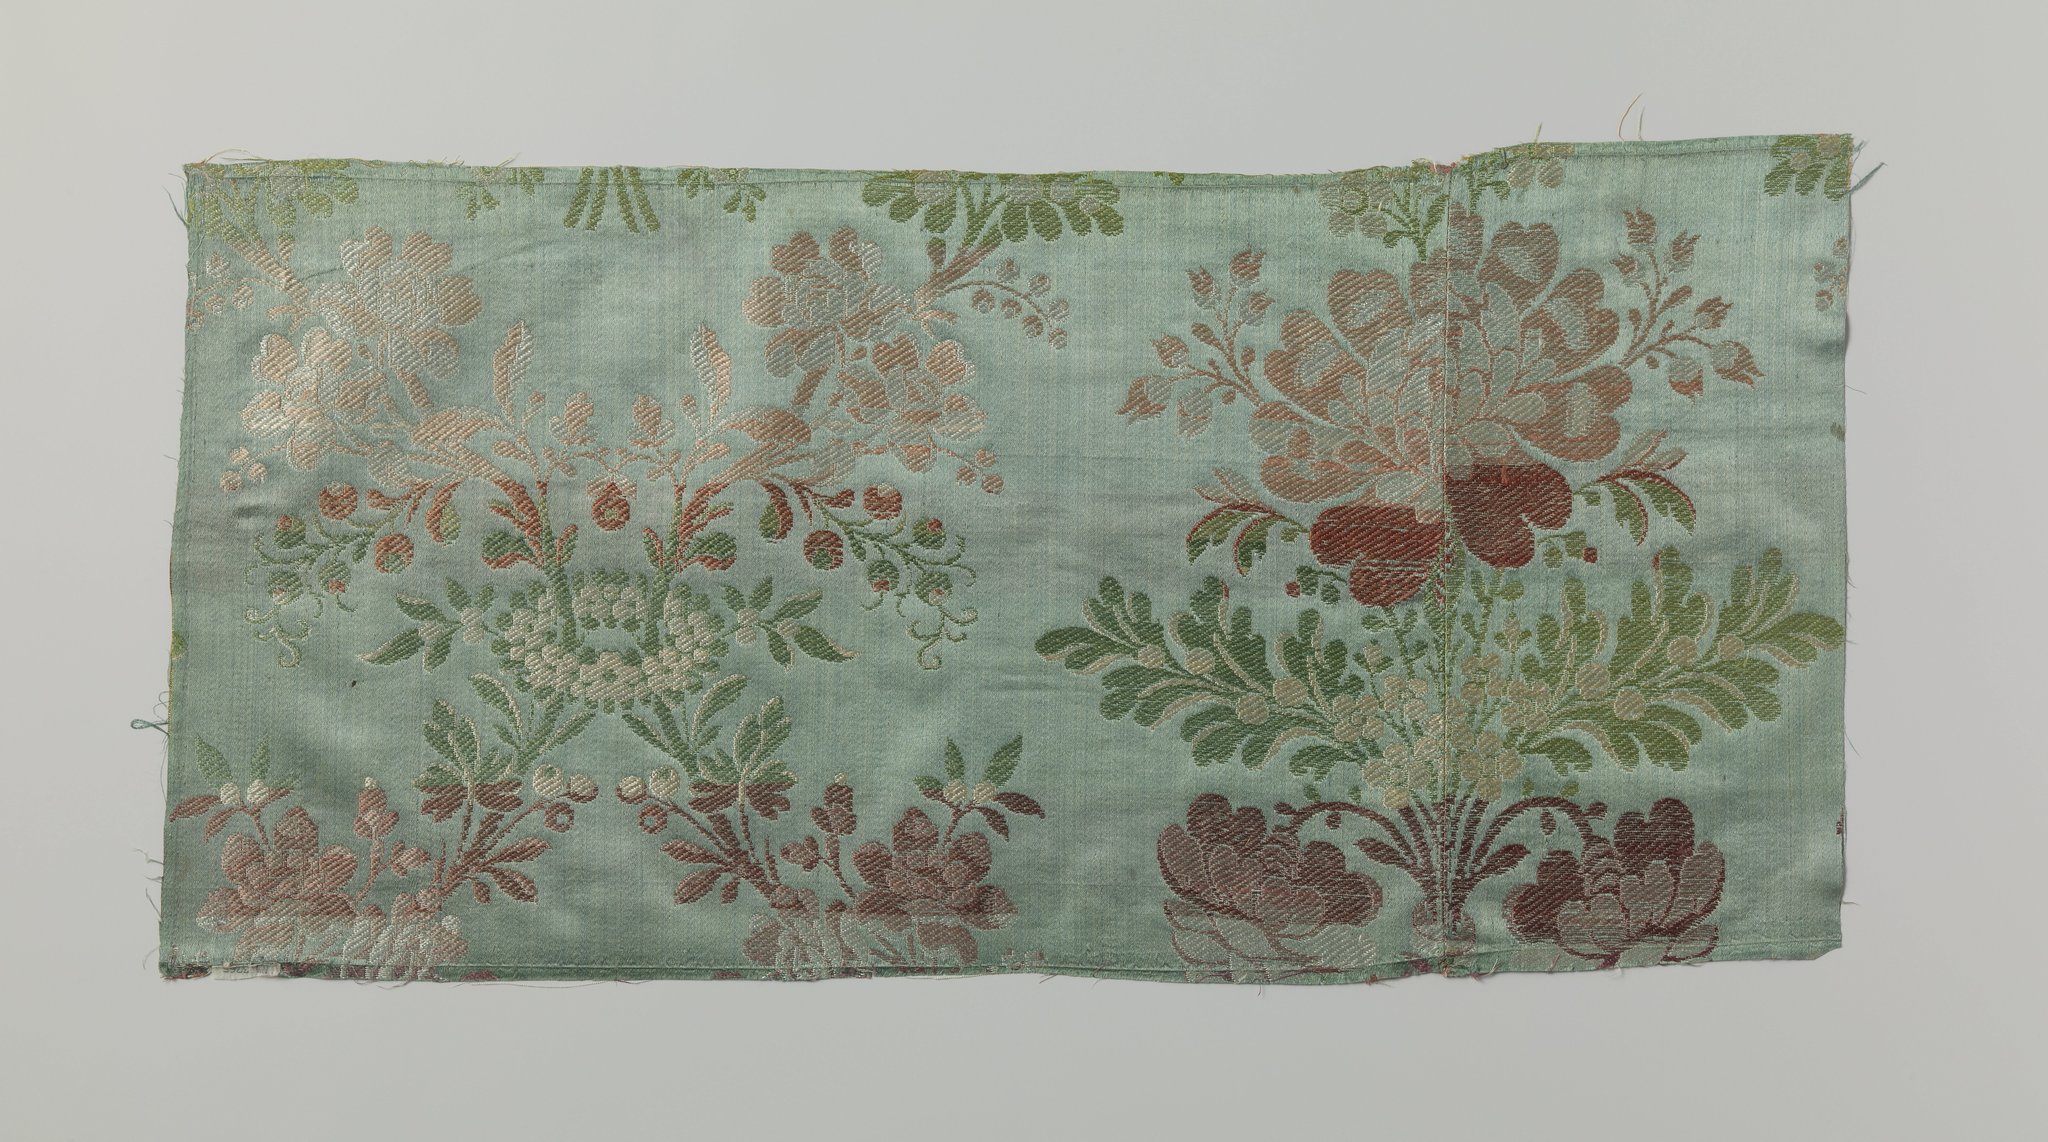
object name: zijdesatijn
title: Fragment veelkleurig zijdesatijn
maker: Anonymous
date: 1750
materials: silk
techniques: liseré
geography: netherlands